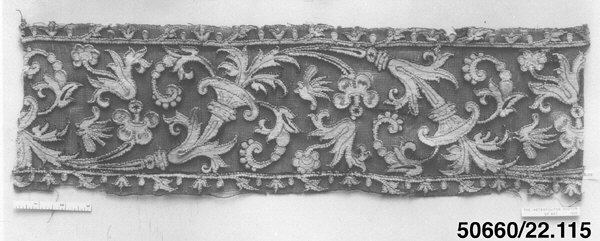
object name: band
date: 1601-1633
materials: linen, silk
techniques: embroidery